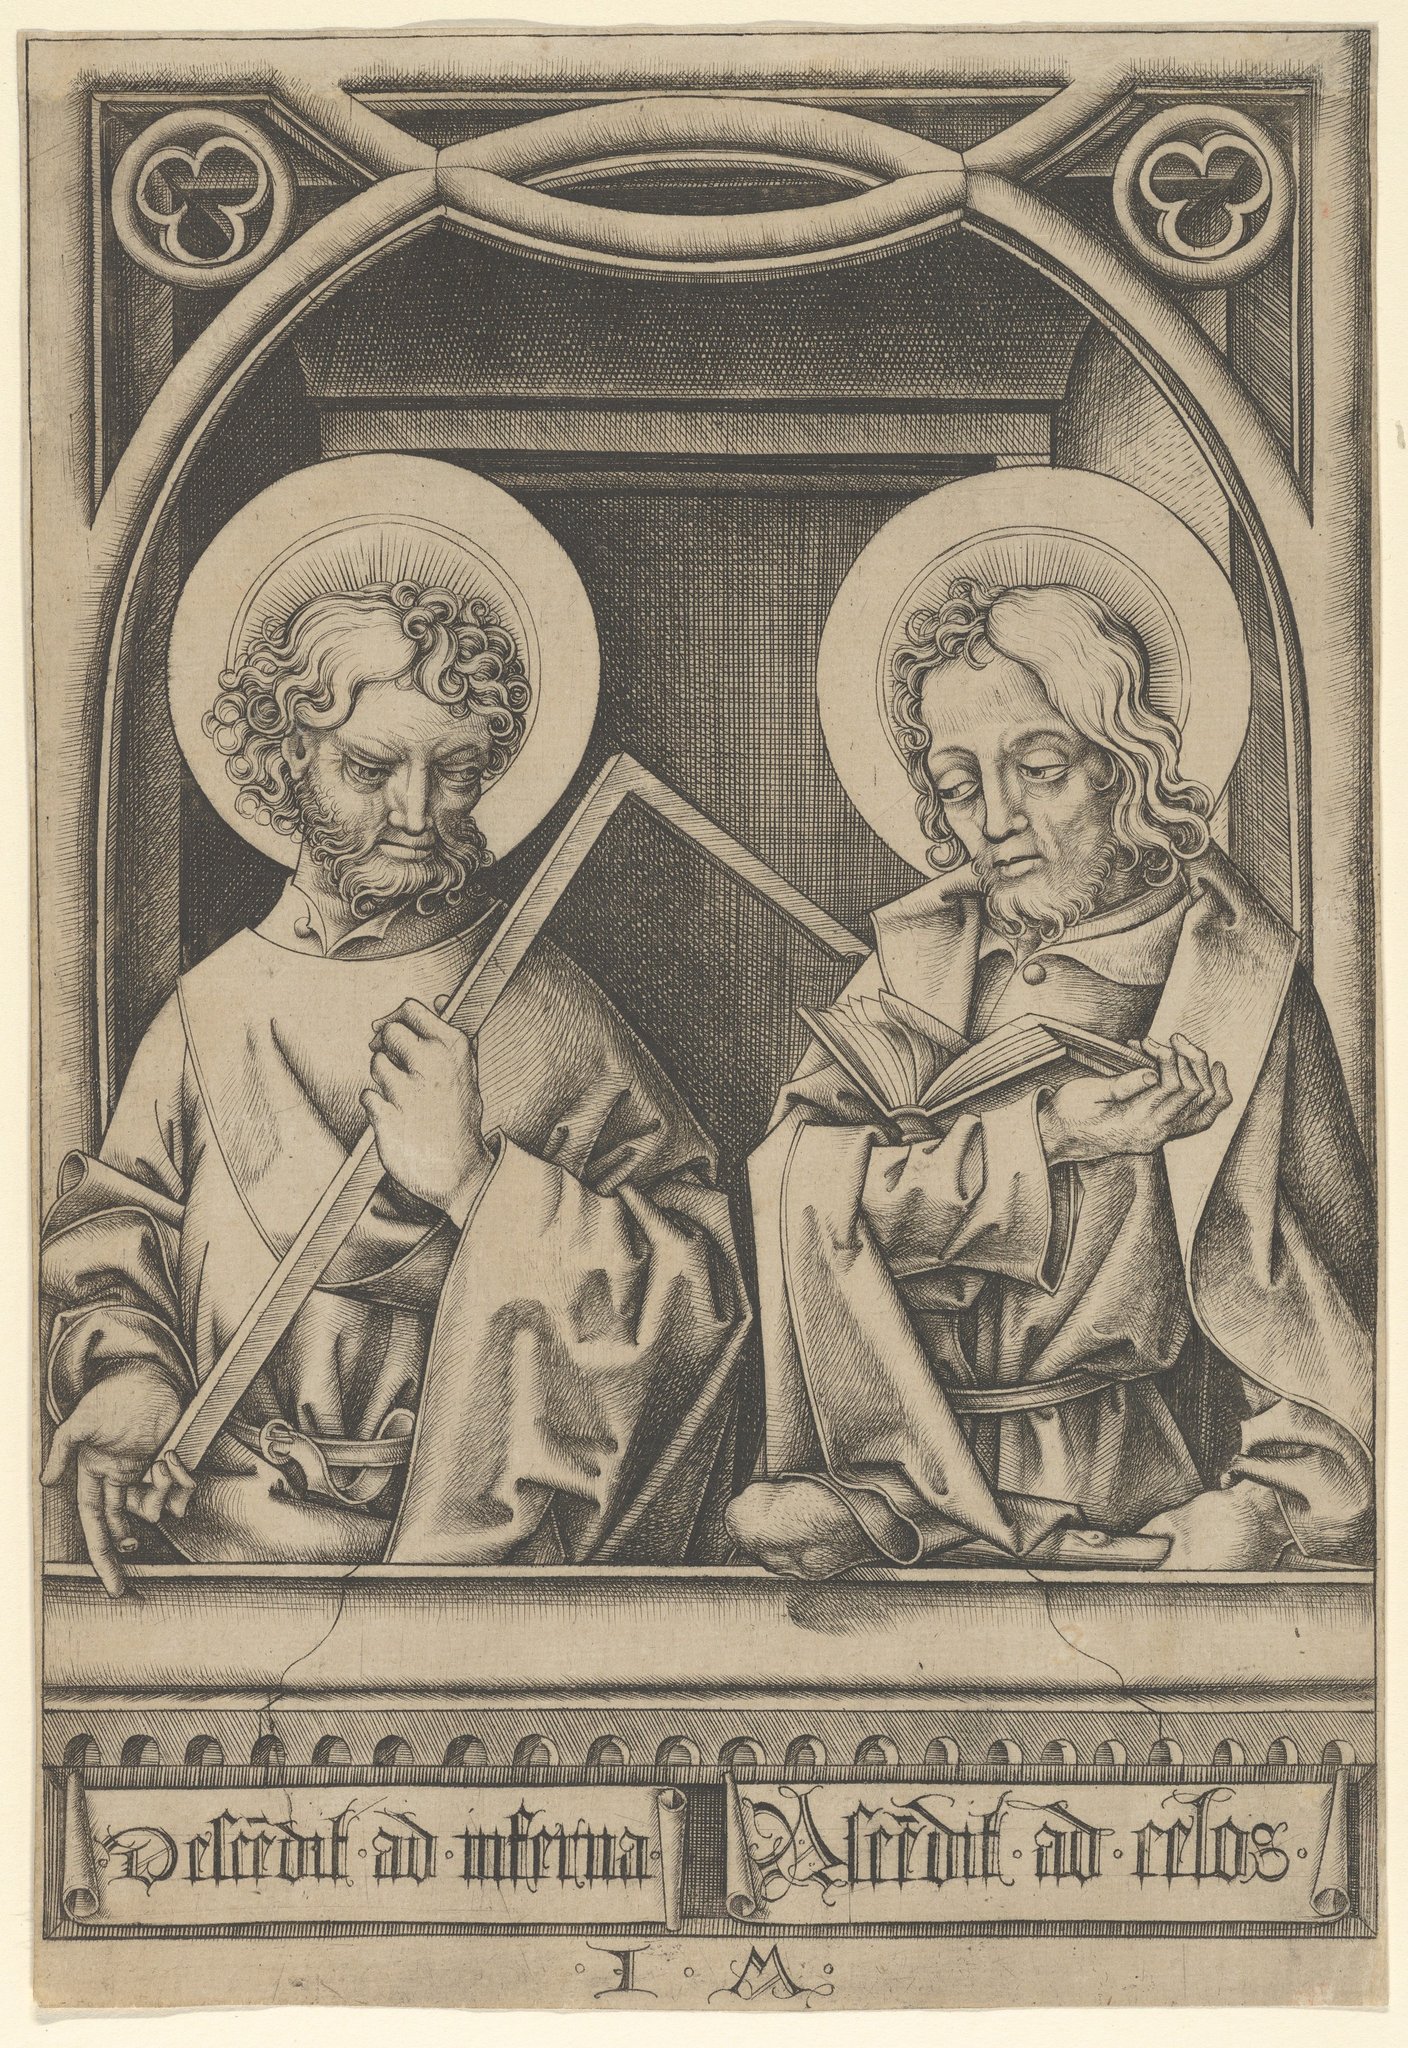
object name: print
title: Saints Thomas and James the Lesser, from The Apostles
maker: israhel van meckenem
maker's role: artist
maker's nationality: german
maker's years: 1435-1503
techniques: engraving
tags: men,apostles,saints